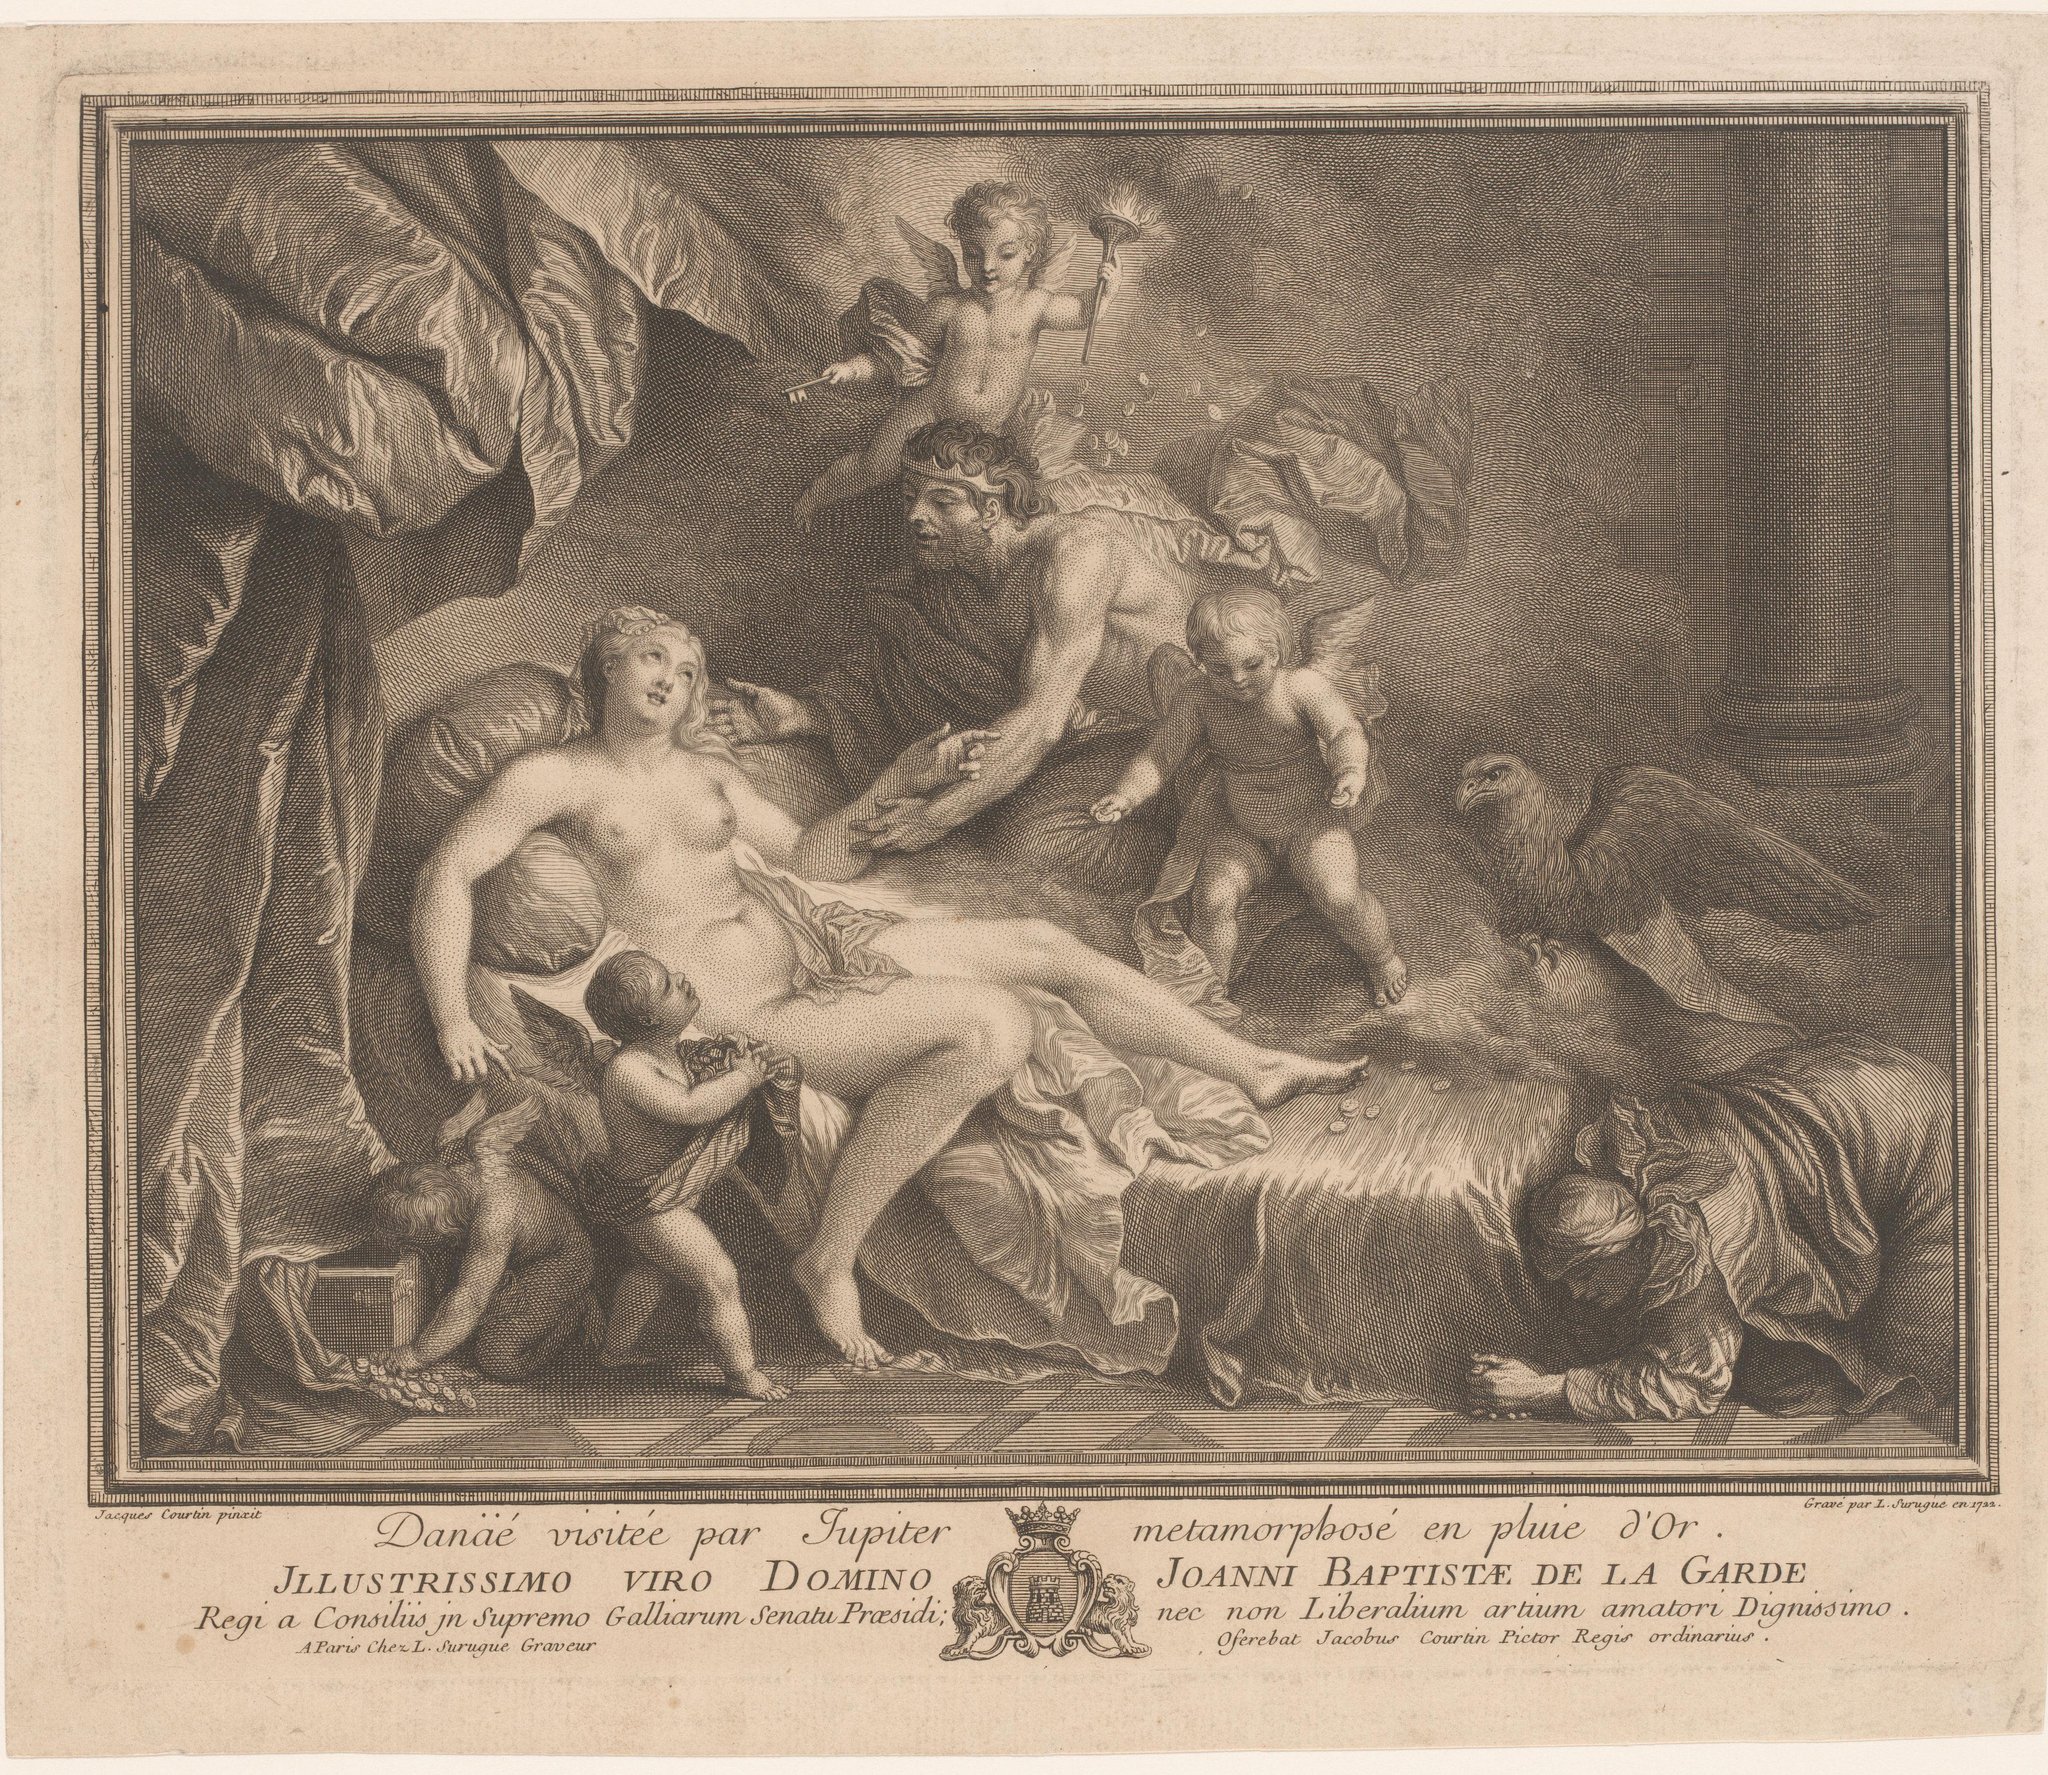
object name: print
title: Jupiter en Danae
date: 1722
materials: paper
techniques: engraving, etching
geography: paris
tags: jupiter wooing danae; she is usually lying in bed receiving a shower of gold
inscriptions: collector's mark: Lugt 2228